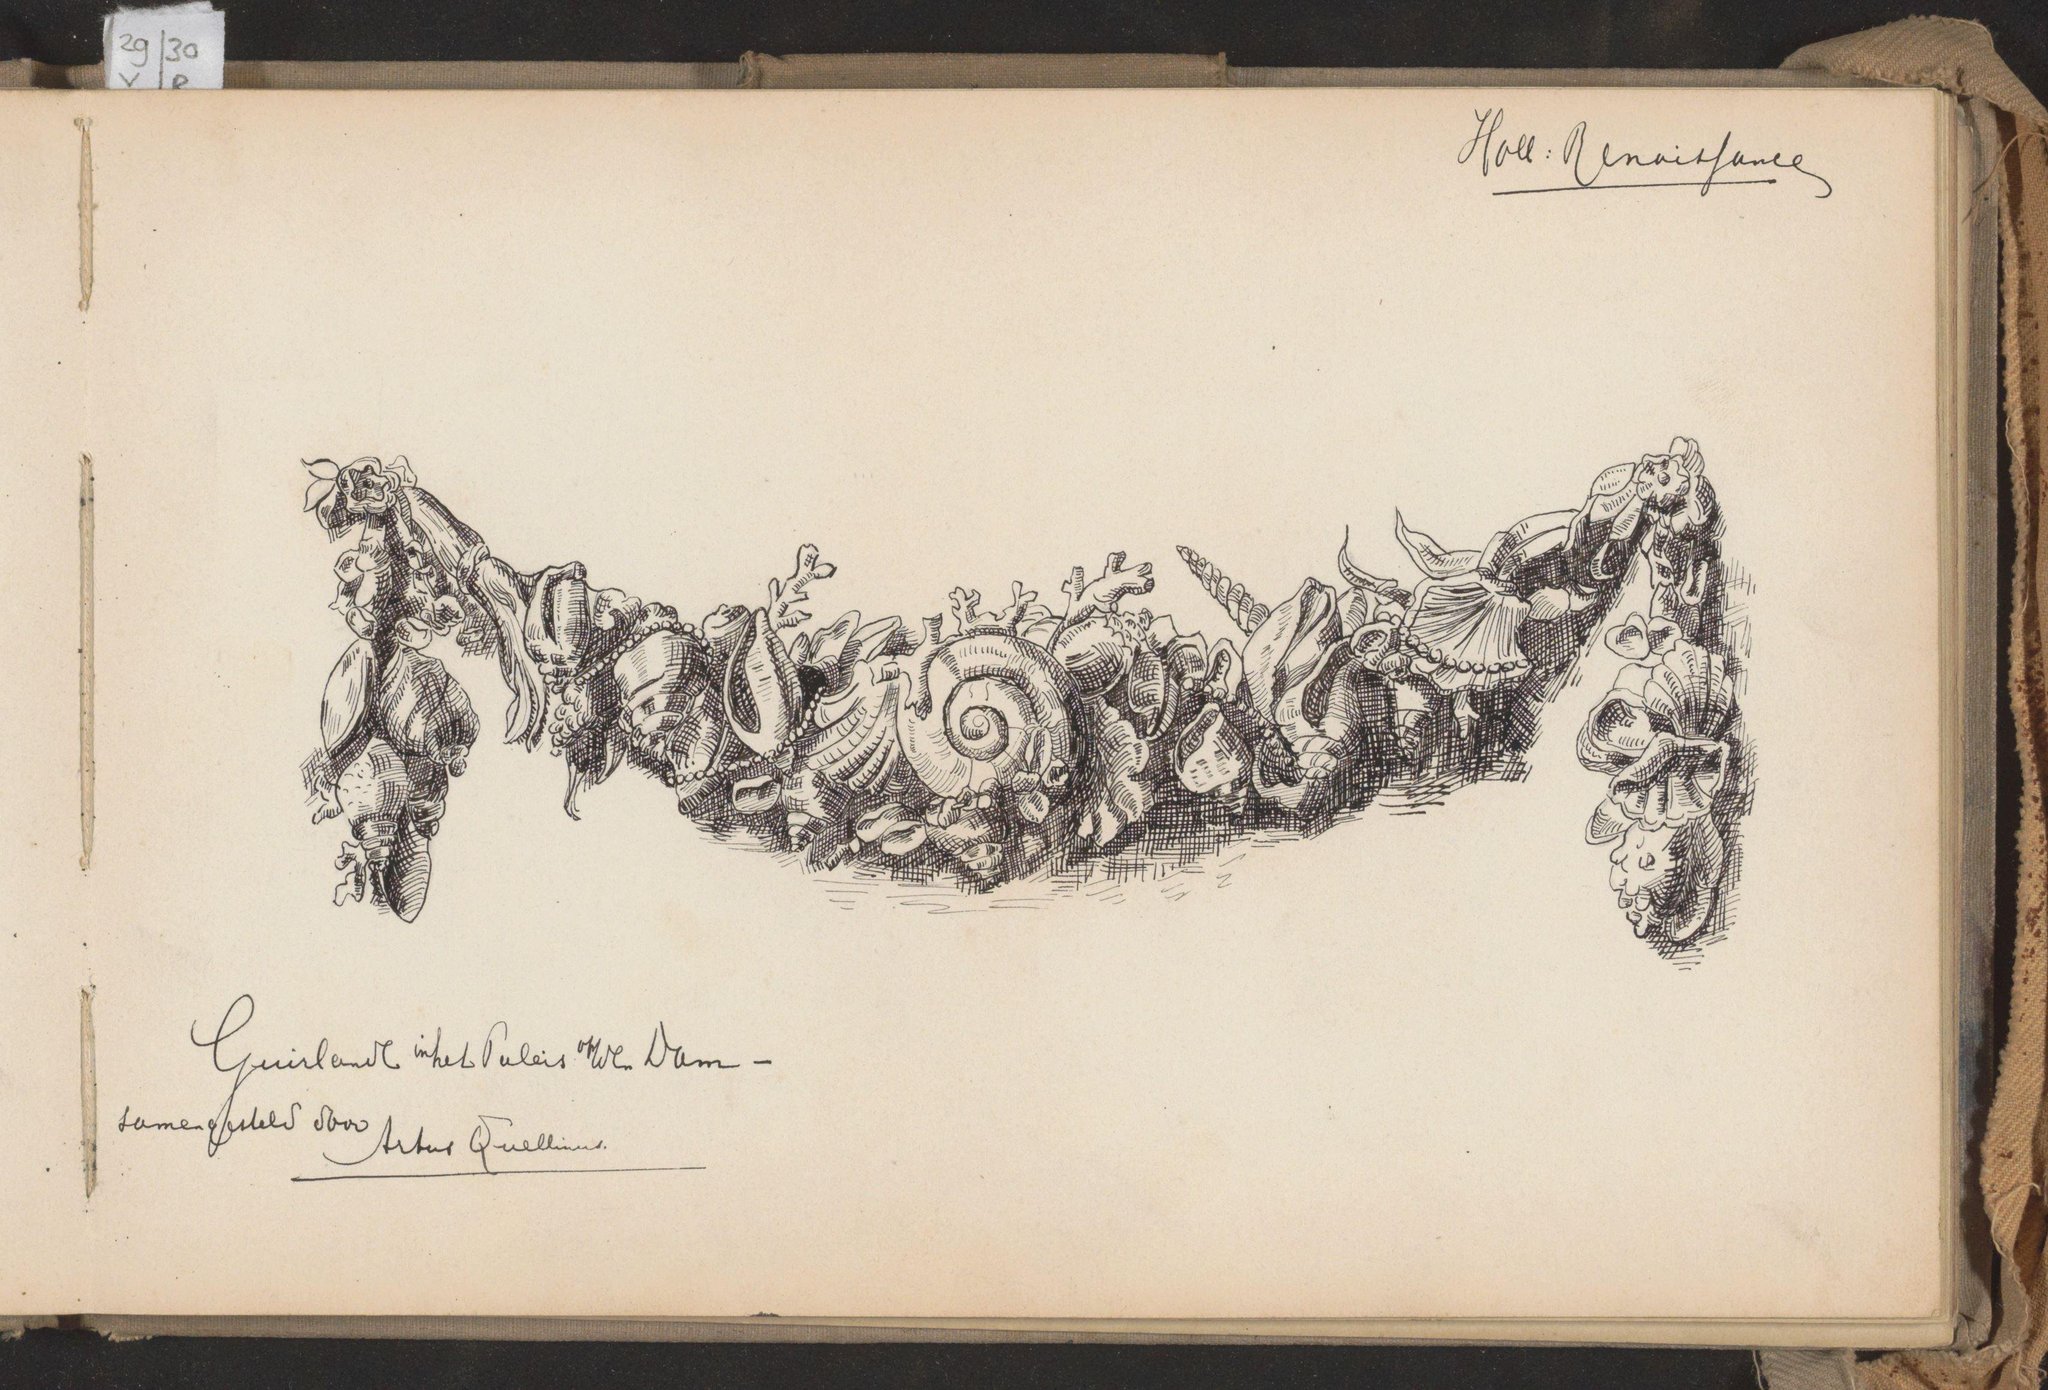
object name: sketchbook leaf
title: Gebeeldhouwde guirlande uit het Paleis op de Dam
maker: johanna van de kamer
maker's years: 1873-1922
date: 1890-1922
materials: ink, paper, pencil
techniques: pen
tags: sculpture, ornament ~ festoon, garland, royal palace of amsterdam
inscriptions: annotation: ‘Guirlande in het Paleis op/den Dam-/ samengesteld door Artus Quellinus’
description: Blad 27 recto uit een schetsboek met 49 bladen.